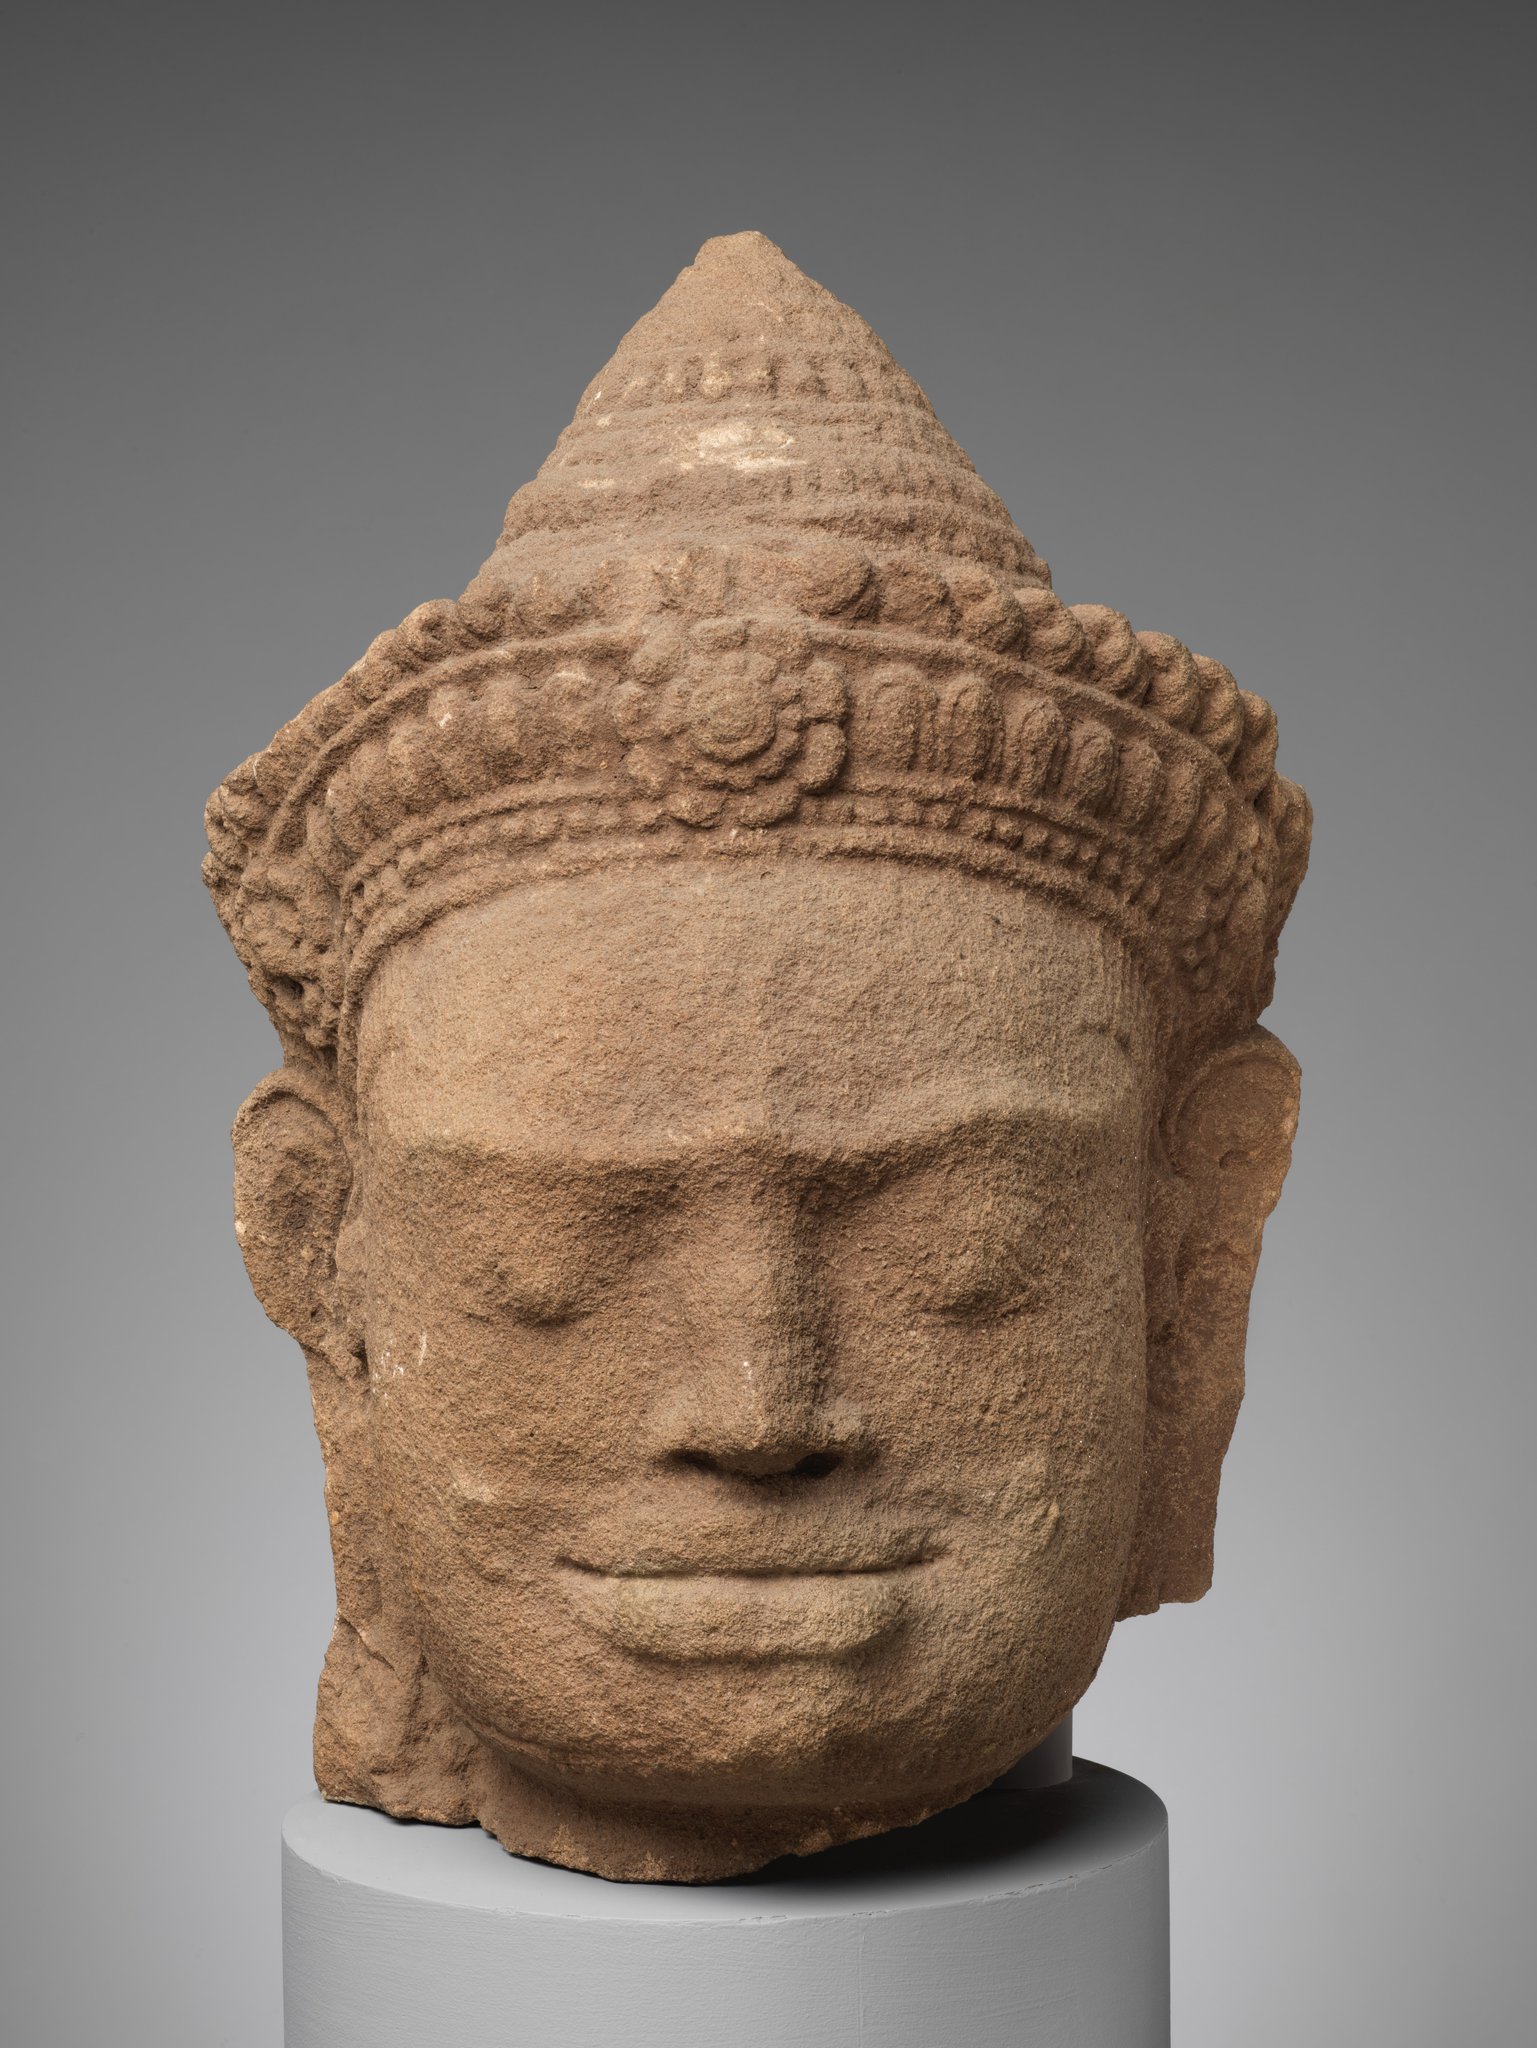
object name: head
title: Head of a Deity(?)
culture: cambodian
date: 1101-1300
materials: stone